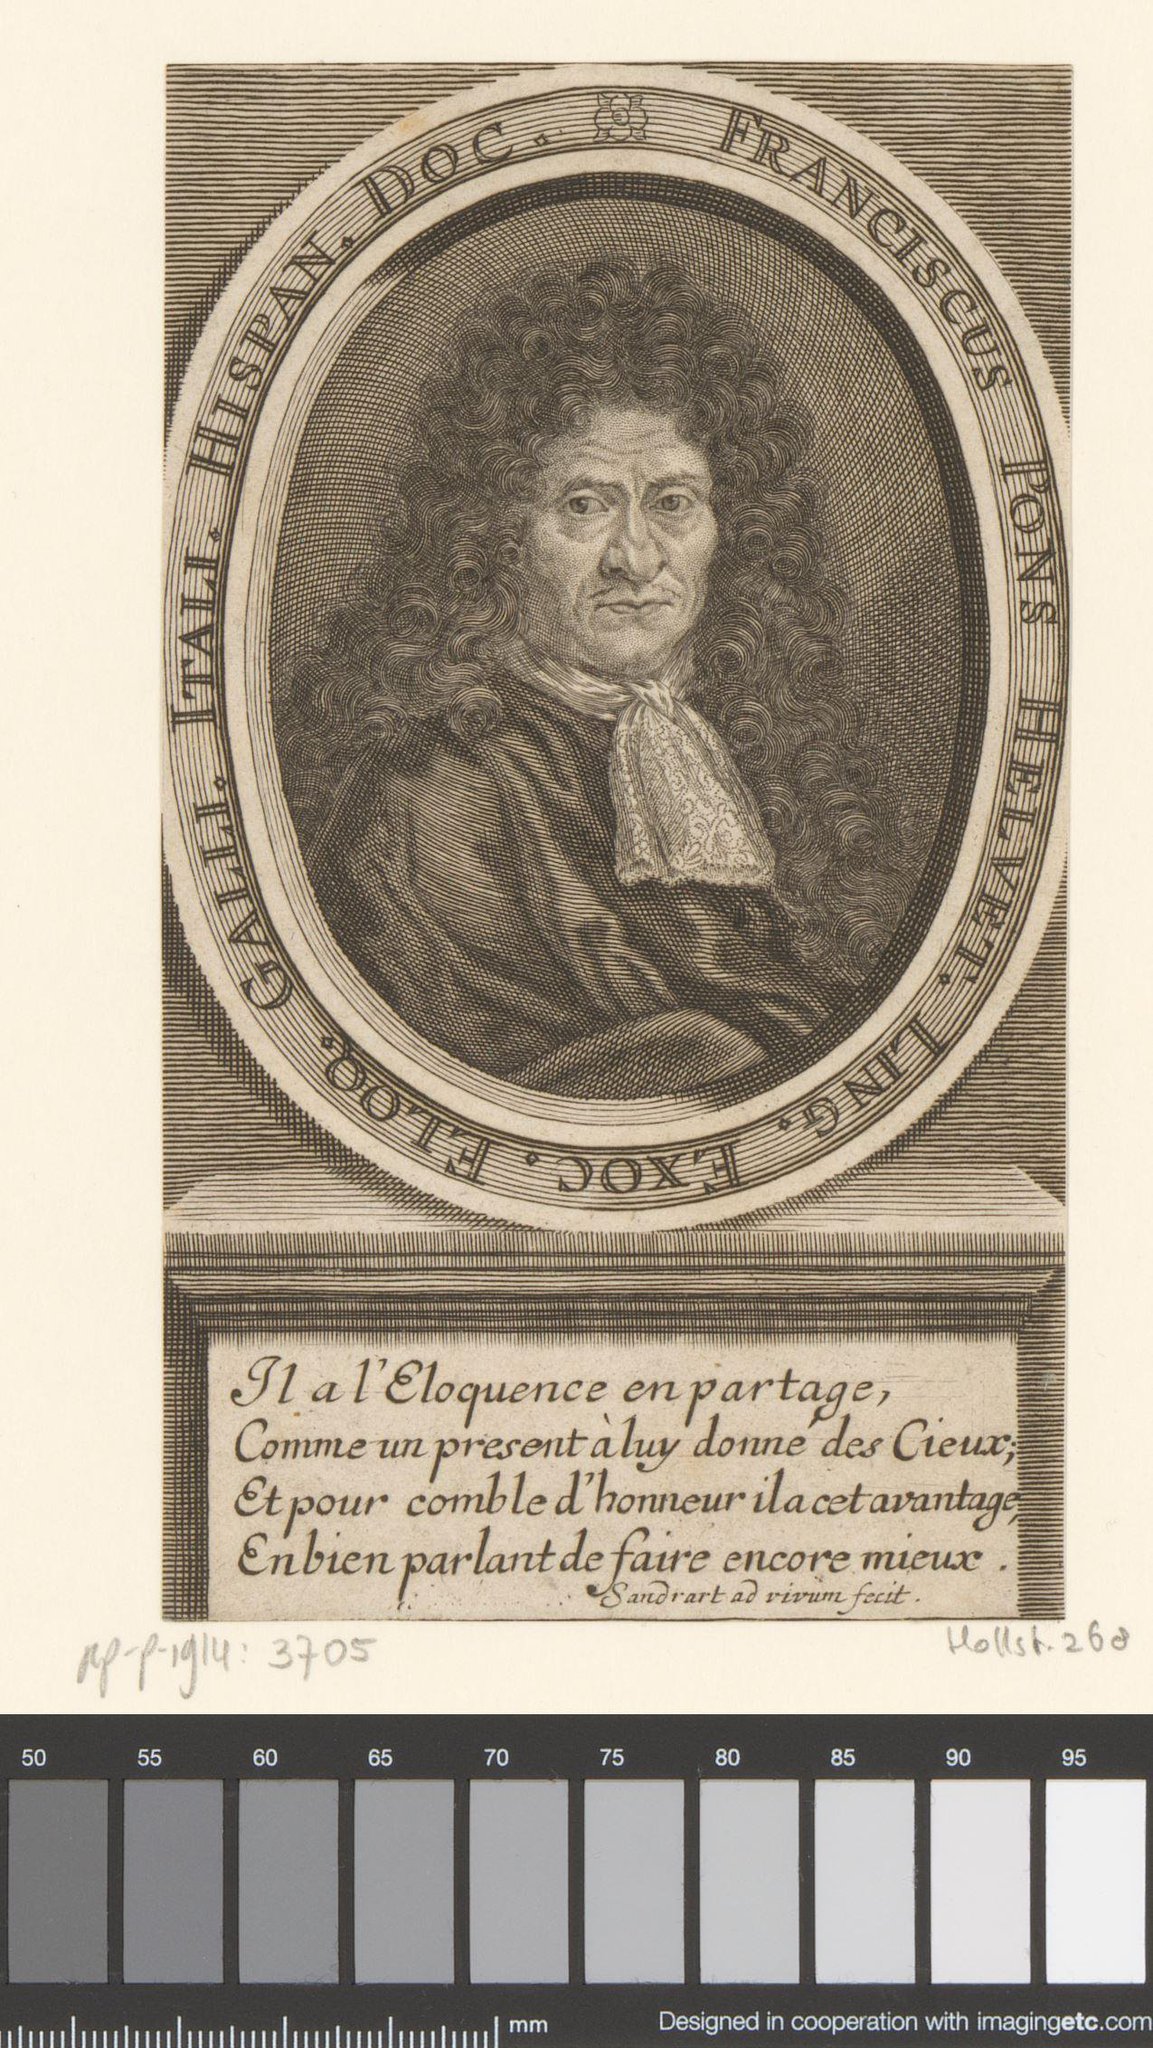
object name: print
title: Portret van Franz Pons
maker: jakob von sandrart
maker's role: print maker, publisher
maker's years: 1630-1708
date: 1691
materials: paper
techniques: engraving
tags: historical persons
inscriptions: collector's mark: Lugt 2228